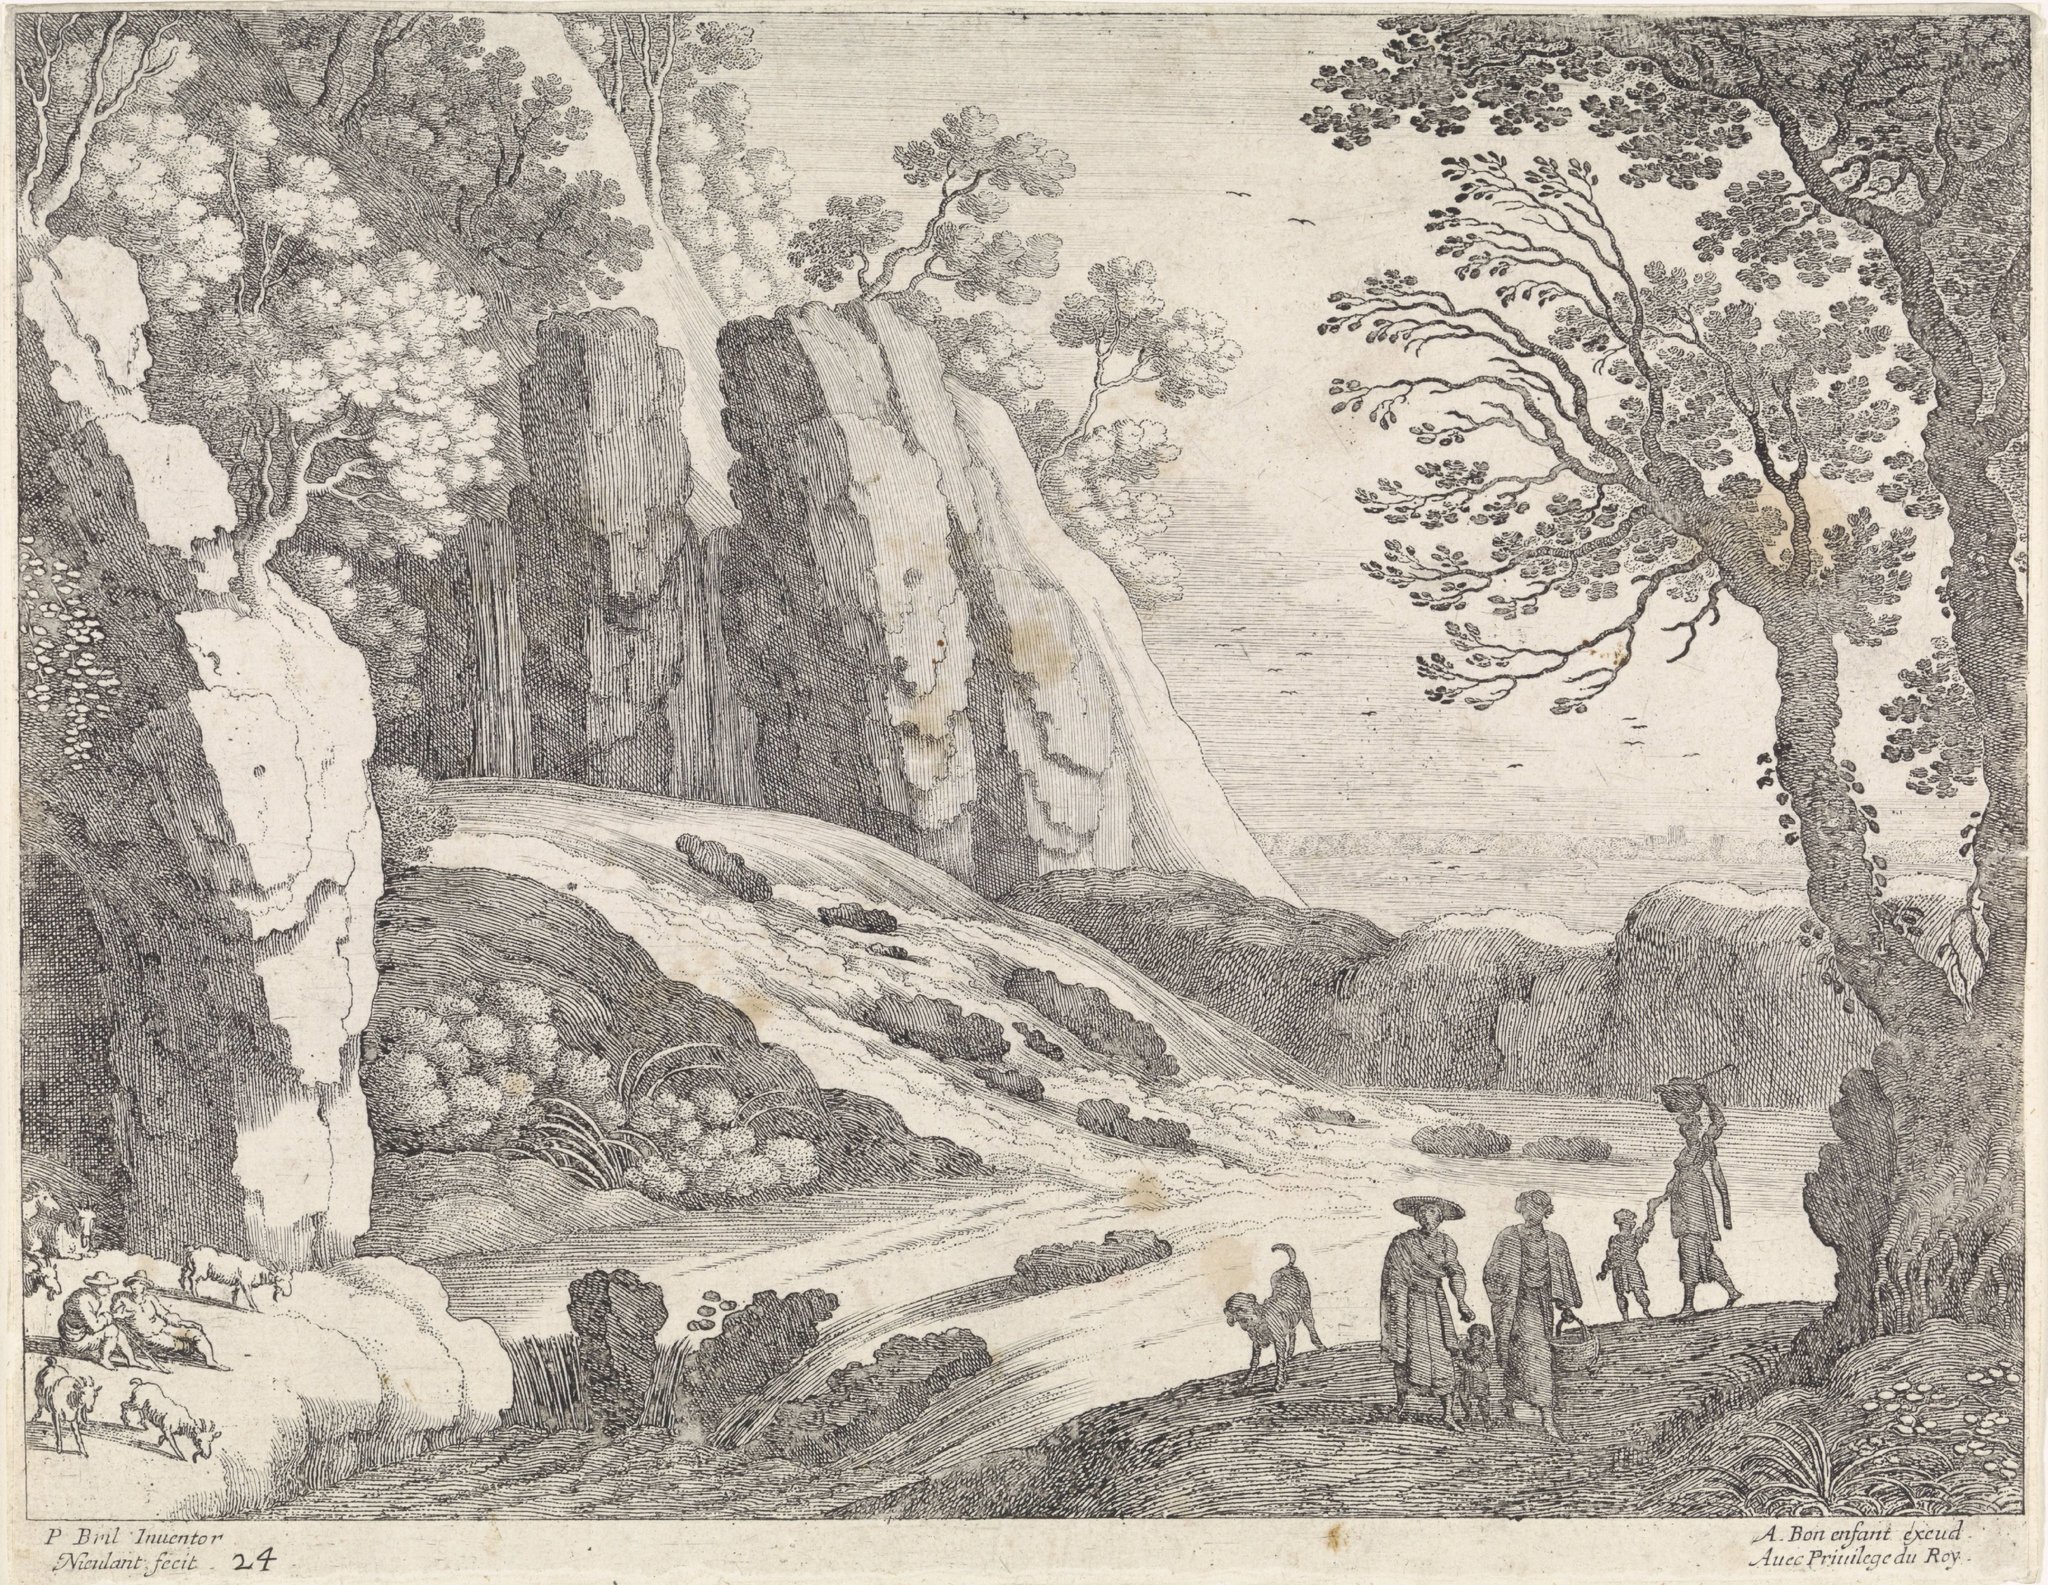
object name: print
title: Figuren bij een waterval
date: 1594-1635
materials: paper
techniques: engraving, etching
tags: herding, herdsman, herdswoman, shepherd, shepherdess, cowherd, etc., waterfall, goat, dog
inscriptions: collector's mark: Lugt 2228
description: Rechts voor een waterval drie vrouwen, twee kinderen en een hond. Links zitten twee herders met hun geiten. Prent uit een serie Italiaanse landschappen.